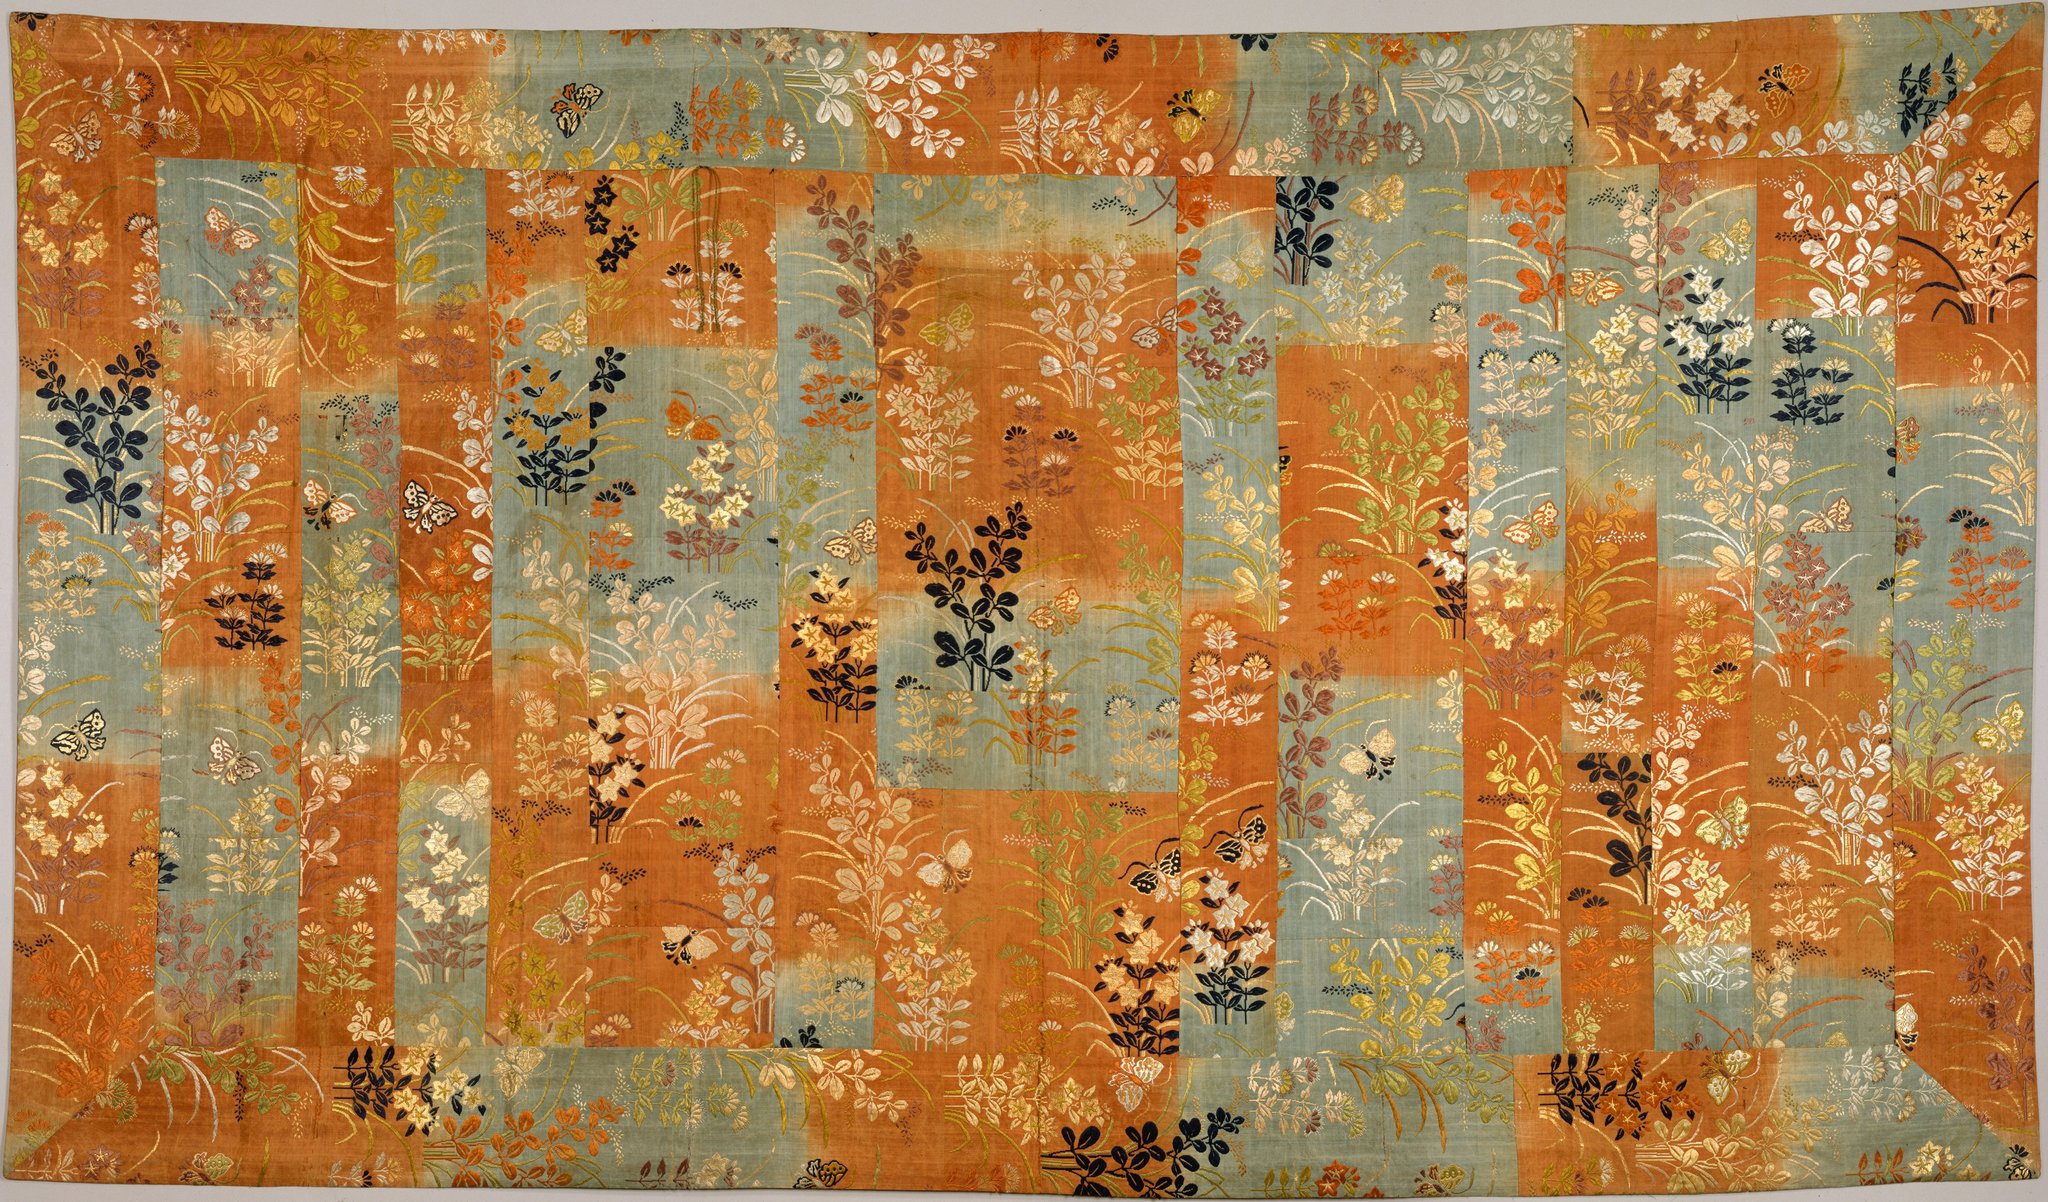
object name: robe, priest's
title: Buddhist Vestment (Kesa) Made from a Noh Costume (Karaori) with Autumn Grasses and Butterflies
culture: japanese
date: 1701-1900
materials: metal thread, silk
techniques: brocade, weave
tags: flowers